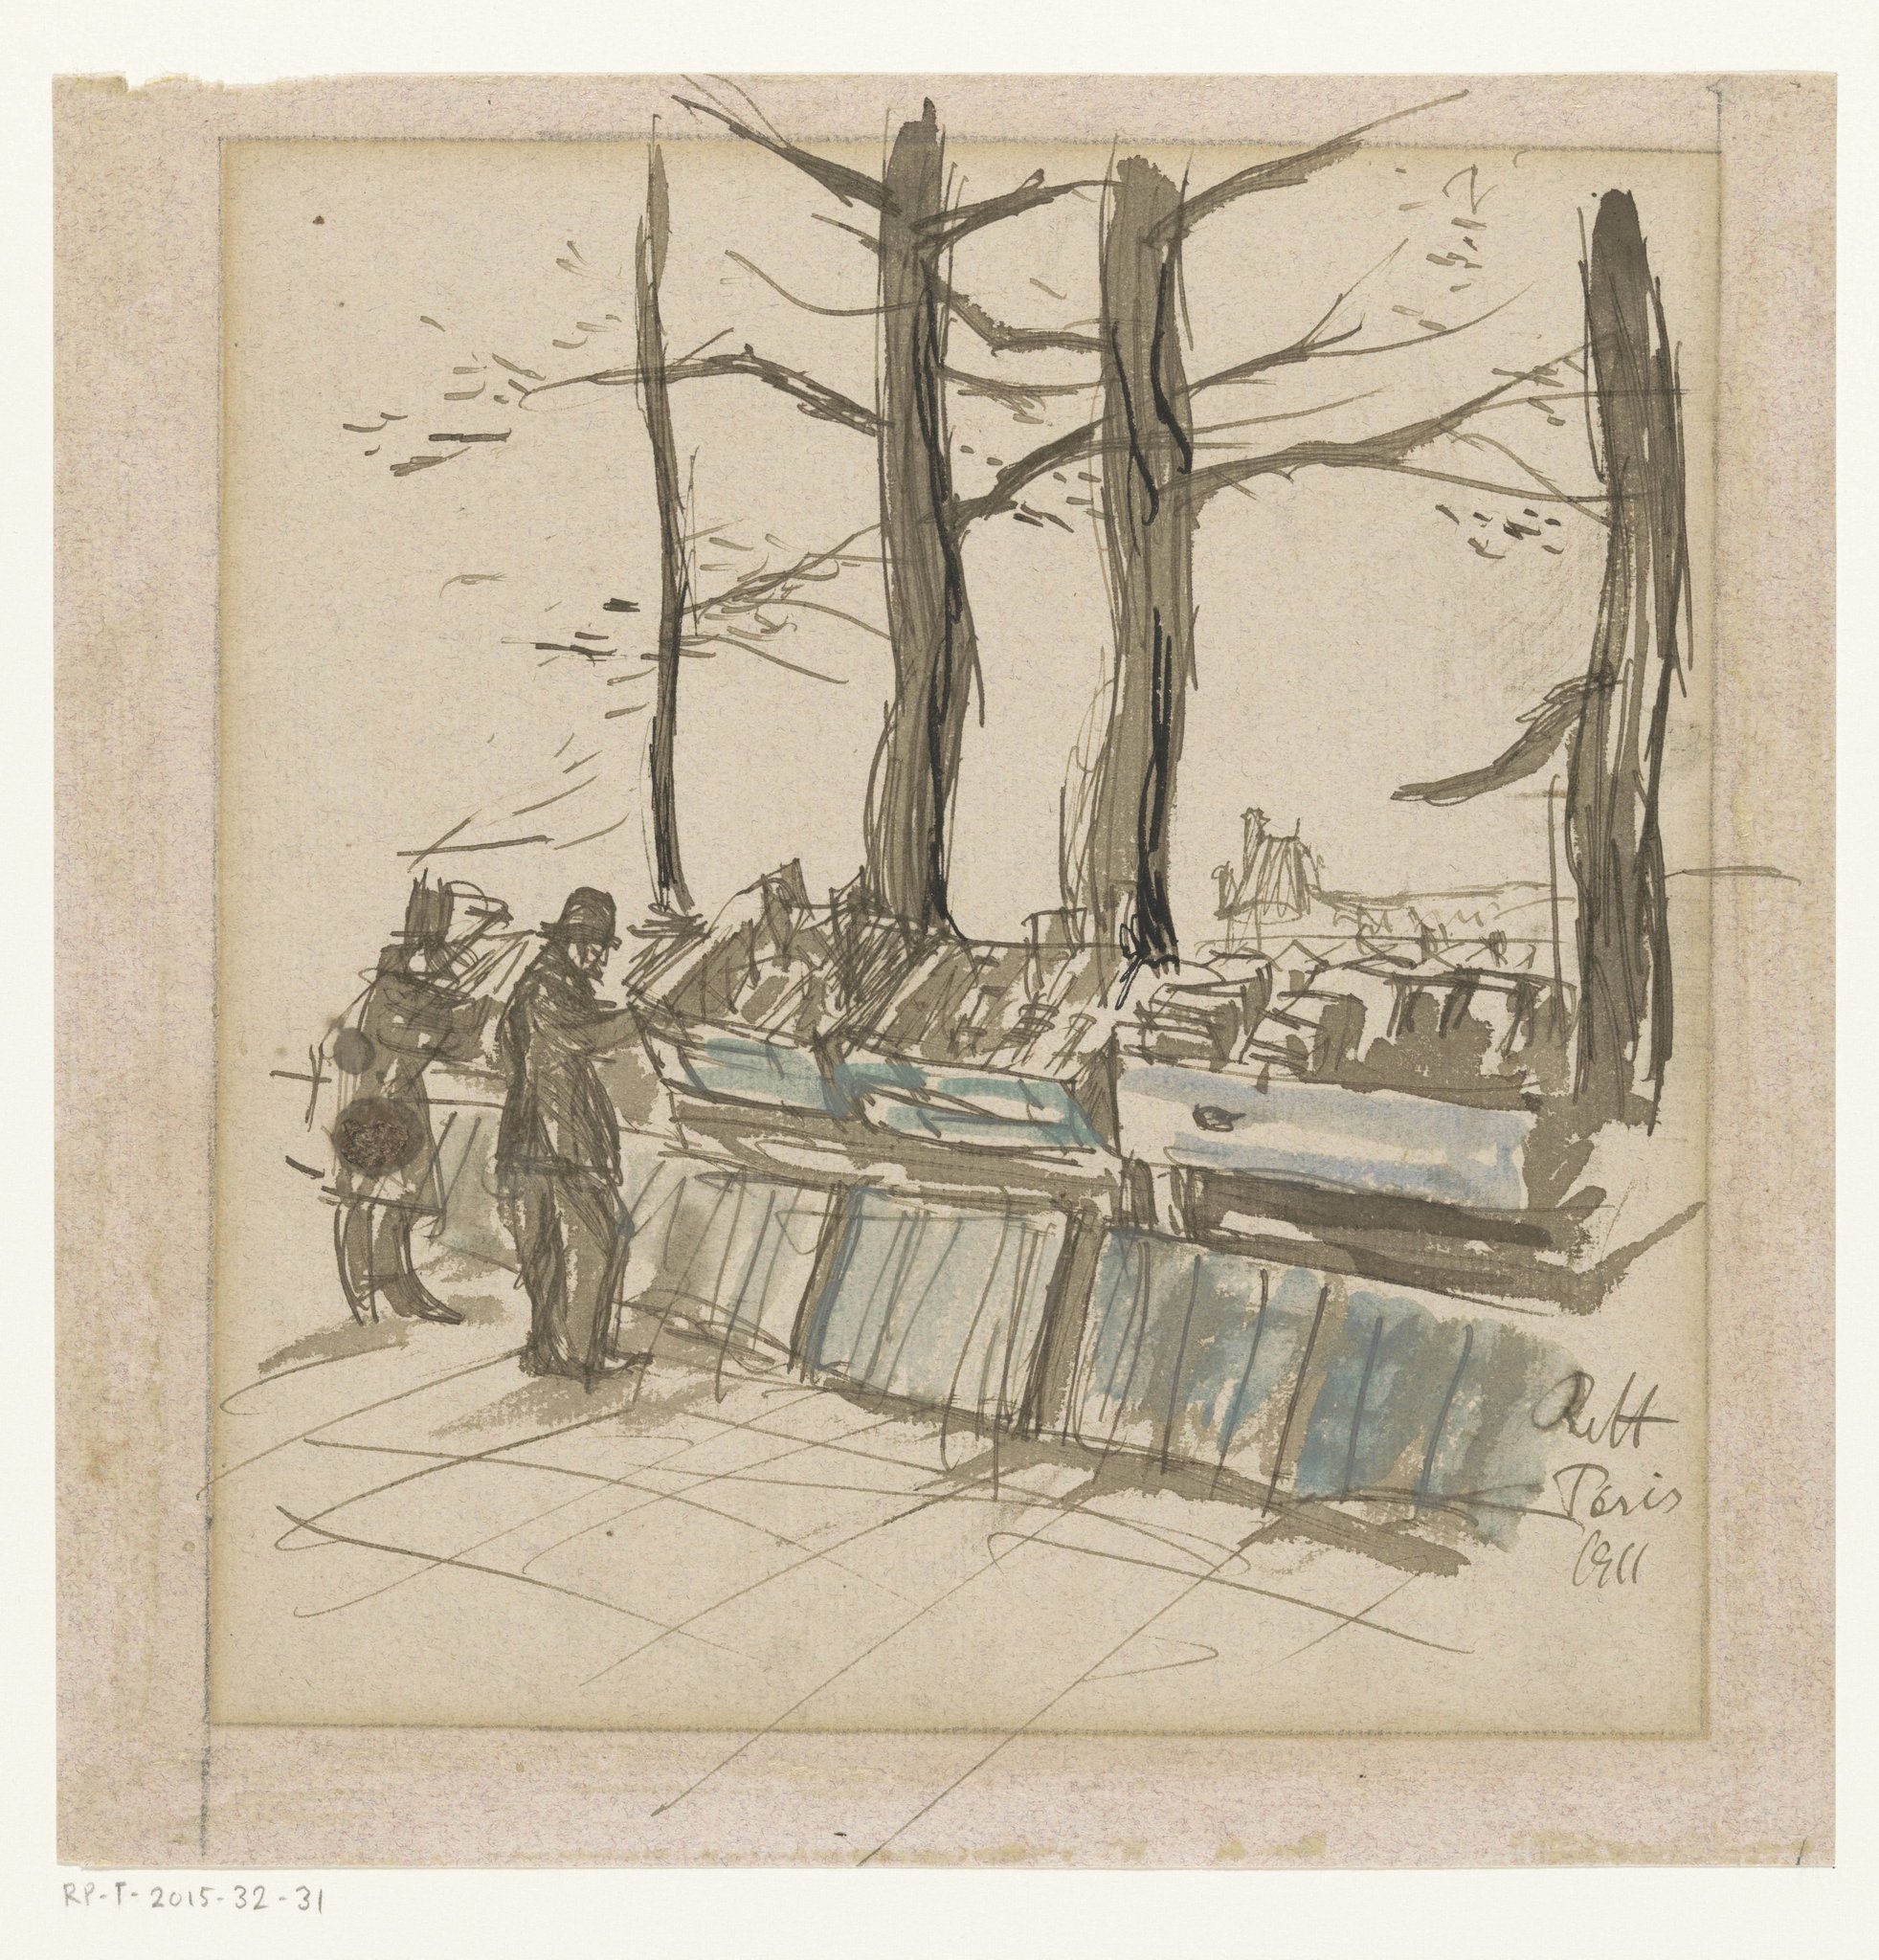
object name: drawing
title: Boekenstallen op een kade in Parijs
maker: rolf von hoerschelmann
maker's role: draughtsman, print maker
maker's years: 1885-1947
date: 1911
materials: ink, paper, watercolor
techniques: brush, pen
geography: paris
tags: book-stall, kiosk, paris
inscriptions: collector's mark, collector's mark: Lugt 2228